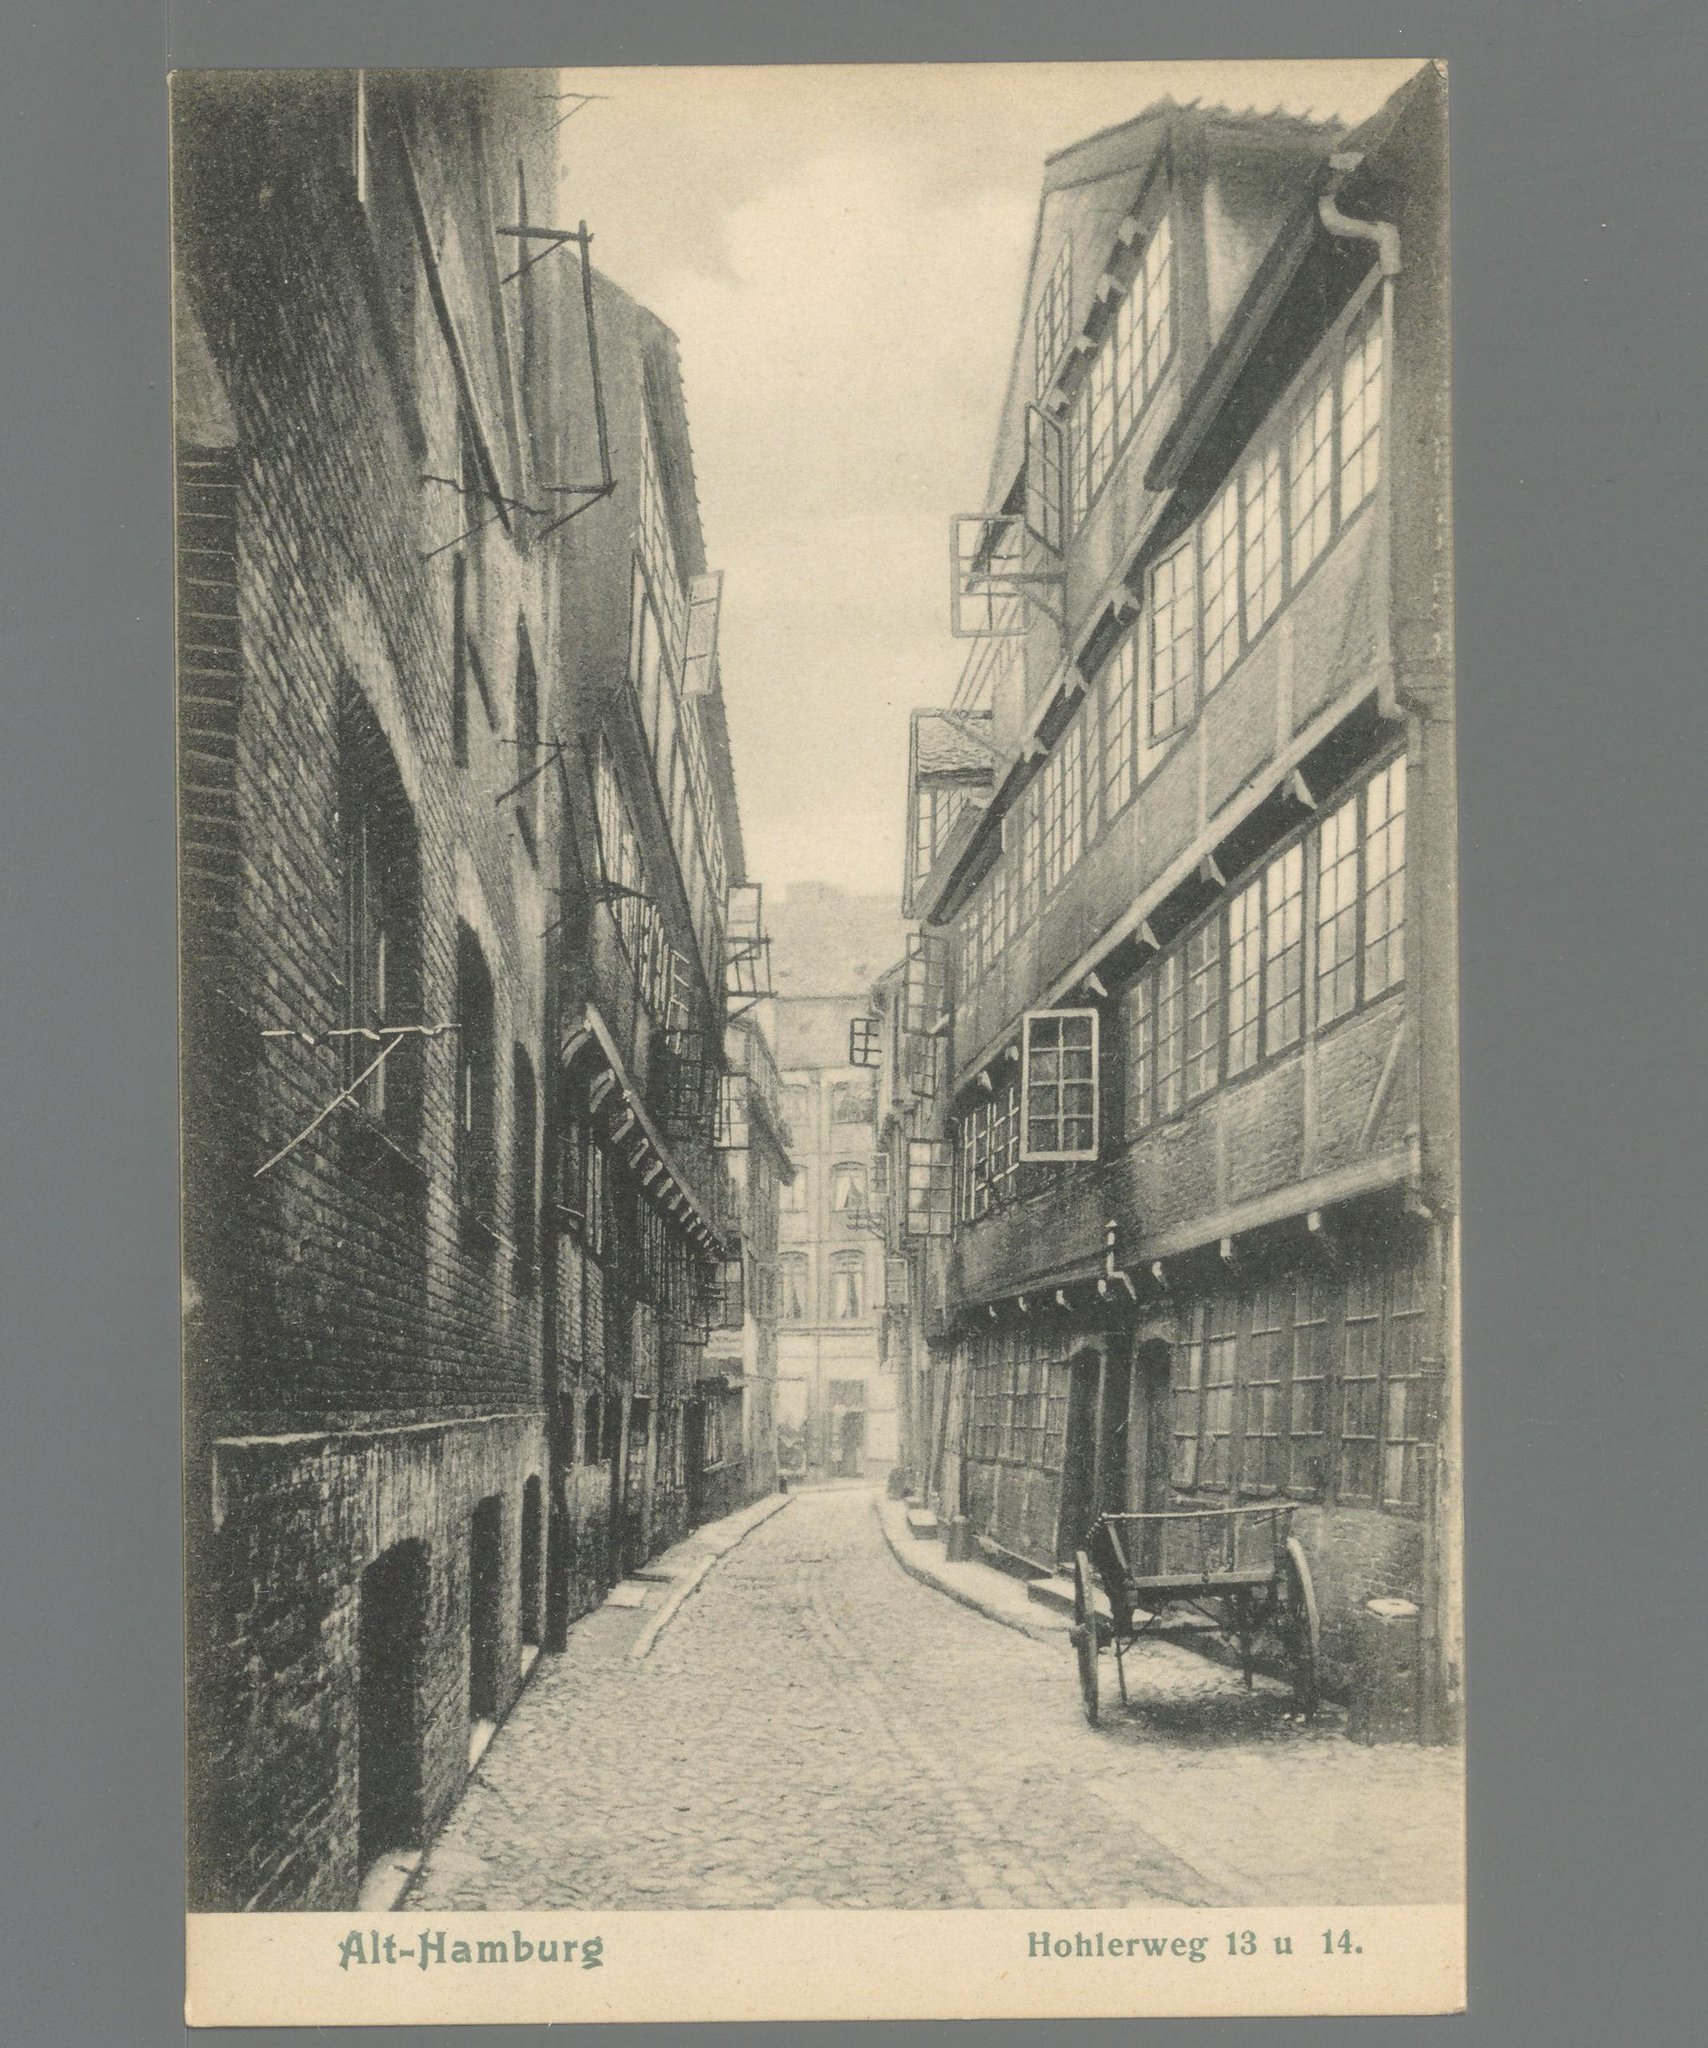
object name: photomechanical print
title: Alt-Hamburg. Hohlerweg 13 u 14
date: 1905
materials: cardboard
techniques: photograph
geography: hamburg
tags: street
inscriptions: date